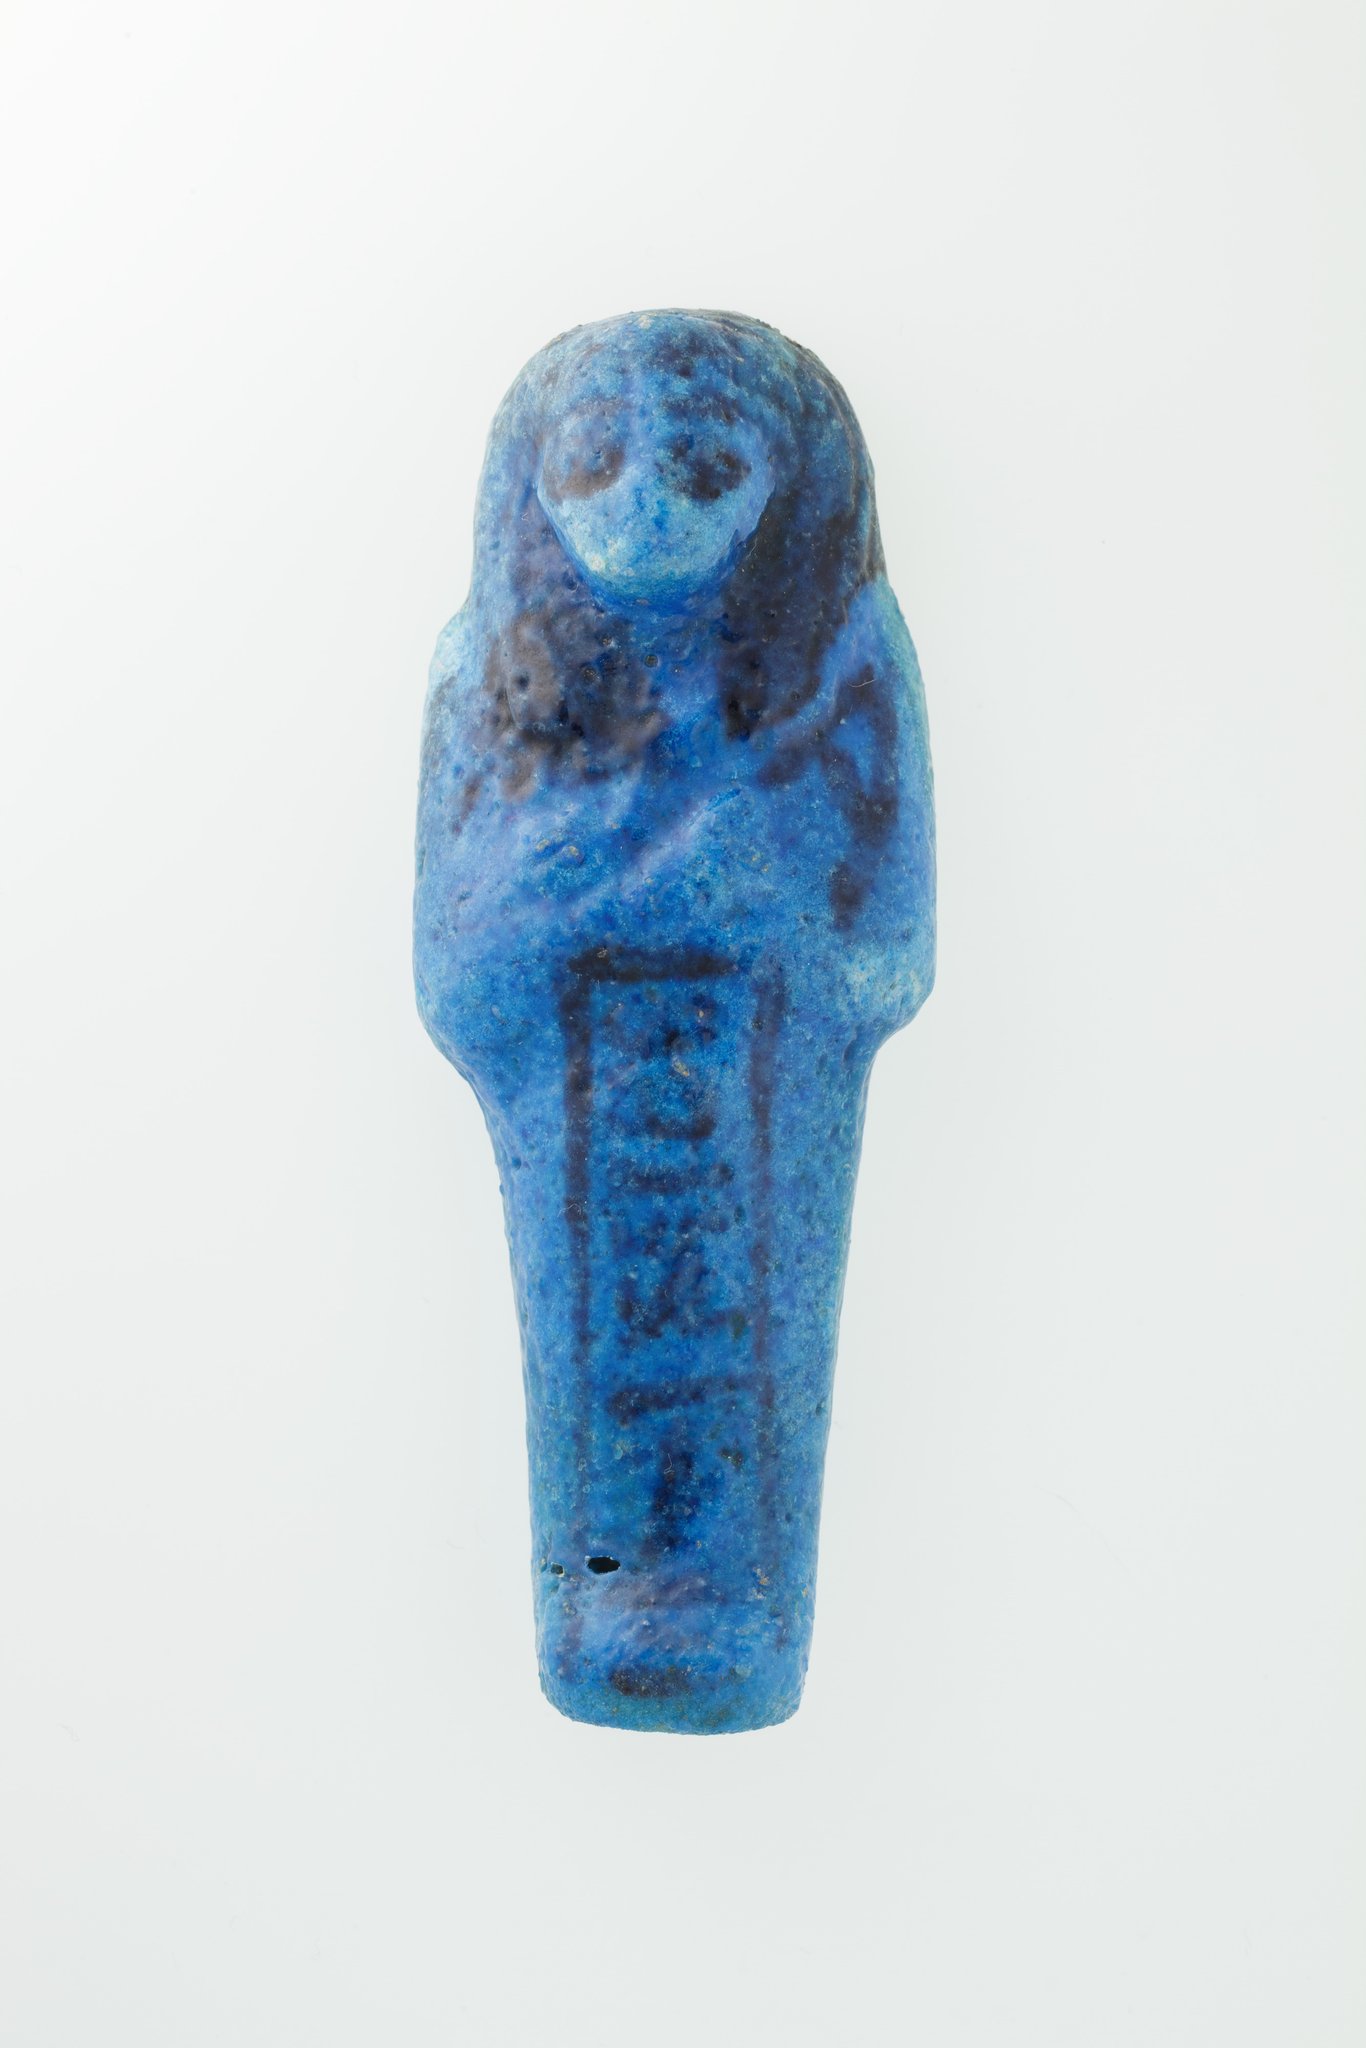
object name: shabti, worker, nauny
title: Worker Shabti of Nauny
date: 1050 BCE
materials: faience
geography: egypt